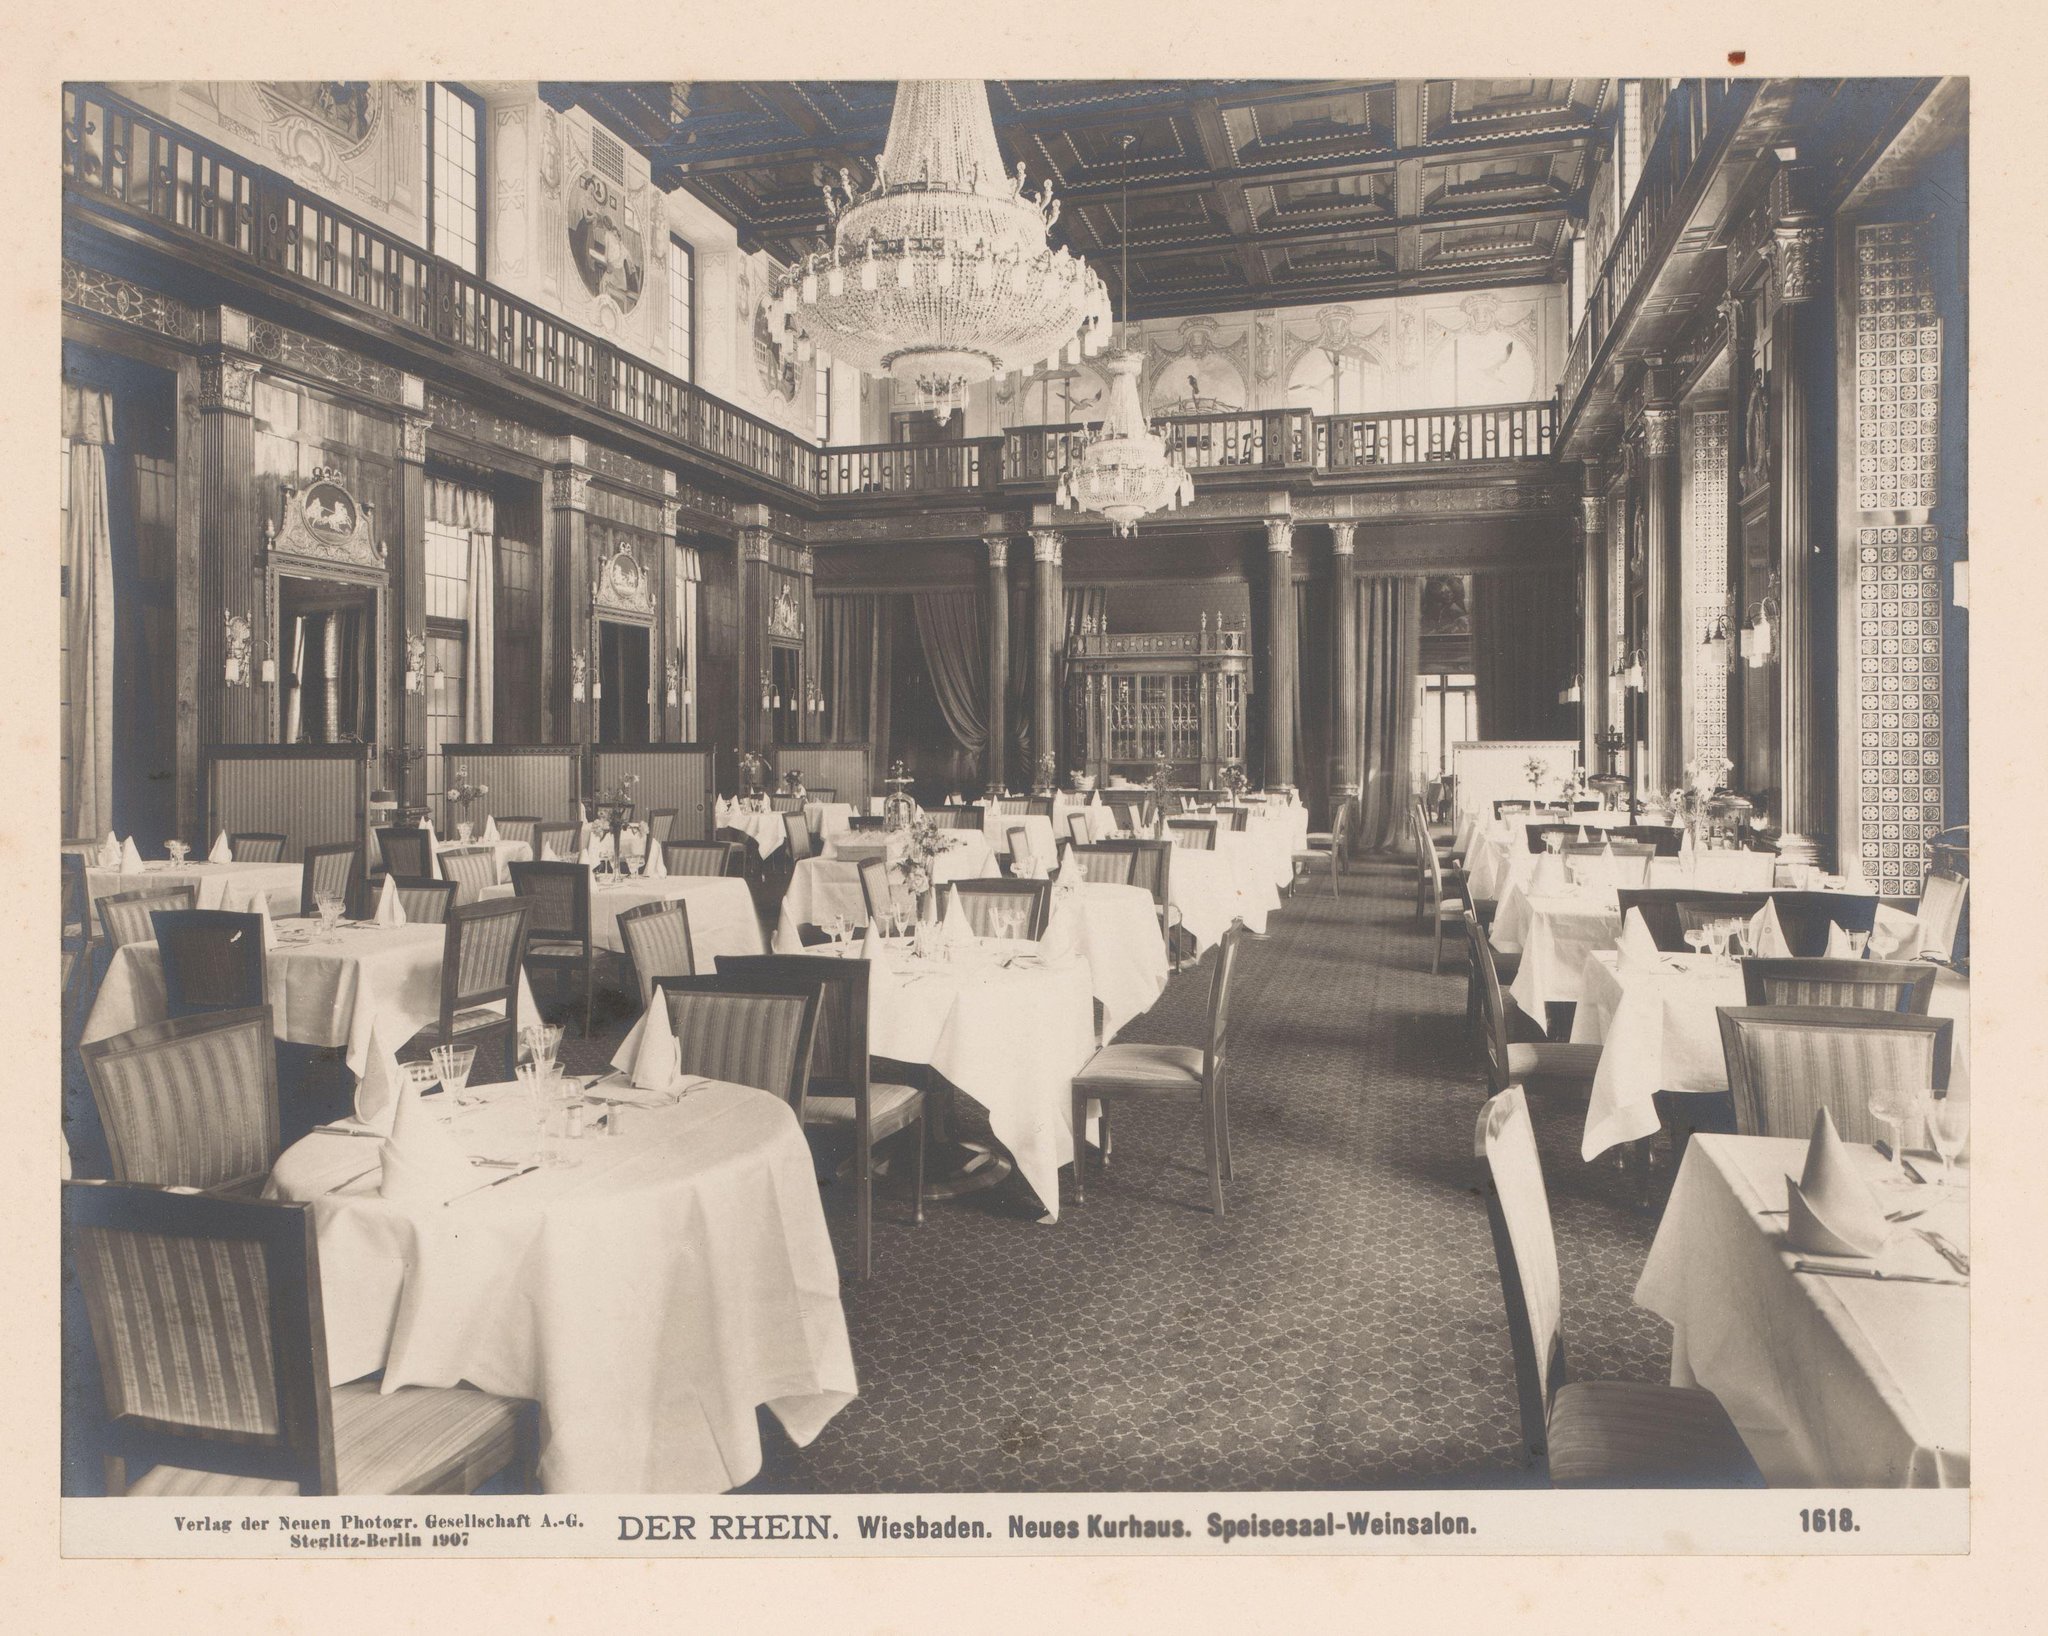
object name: photograph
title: Speisesaal/Weinsalon, Neues Kurhaus, Wiesbaden, Duitsland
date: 1907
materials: cardboard, paper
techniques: albumen print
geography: berlin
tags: wiesbaden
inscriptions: caption: ‘DER RHEIN. Wiesbaden. Neues Kurhaus. Speisesaal-Weinsalon.’, name: ‘Neue Photographische Gesellschaft A. G.//Steglitz-Berlin 1907’, number: ‘1618.’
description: Speisesaal/Weinsalon, Neues Kurhaus, Wiesbaden, Duitsland.